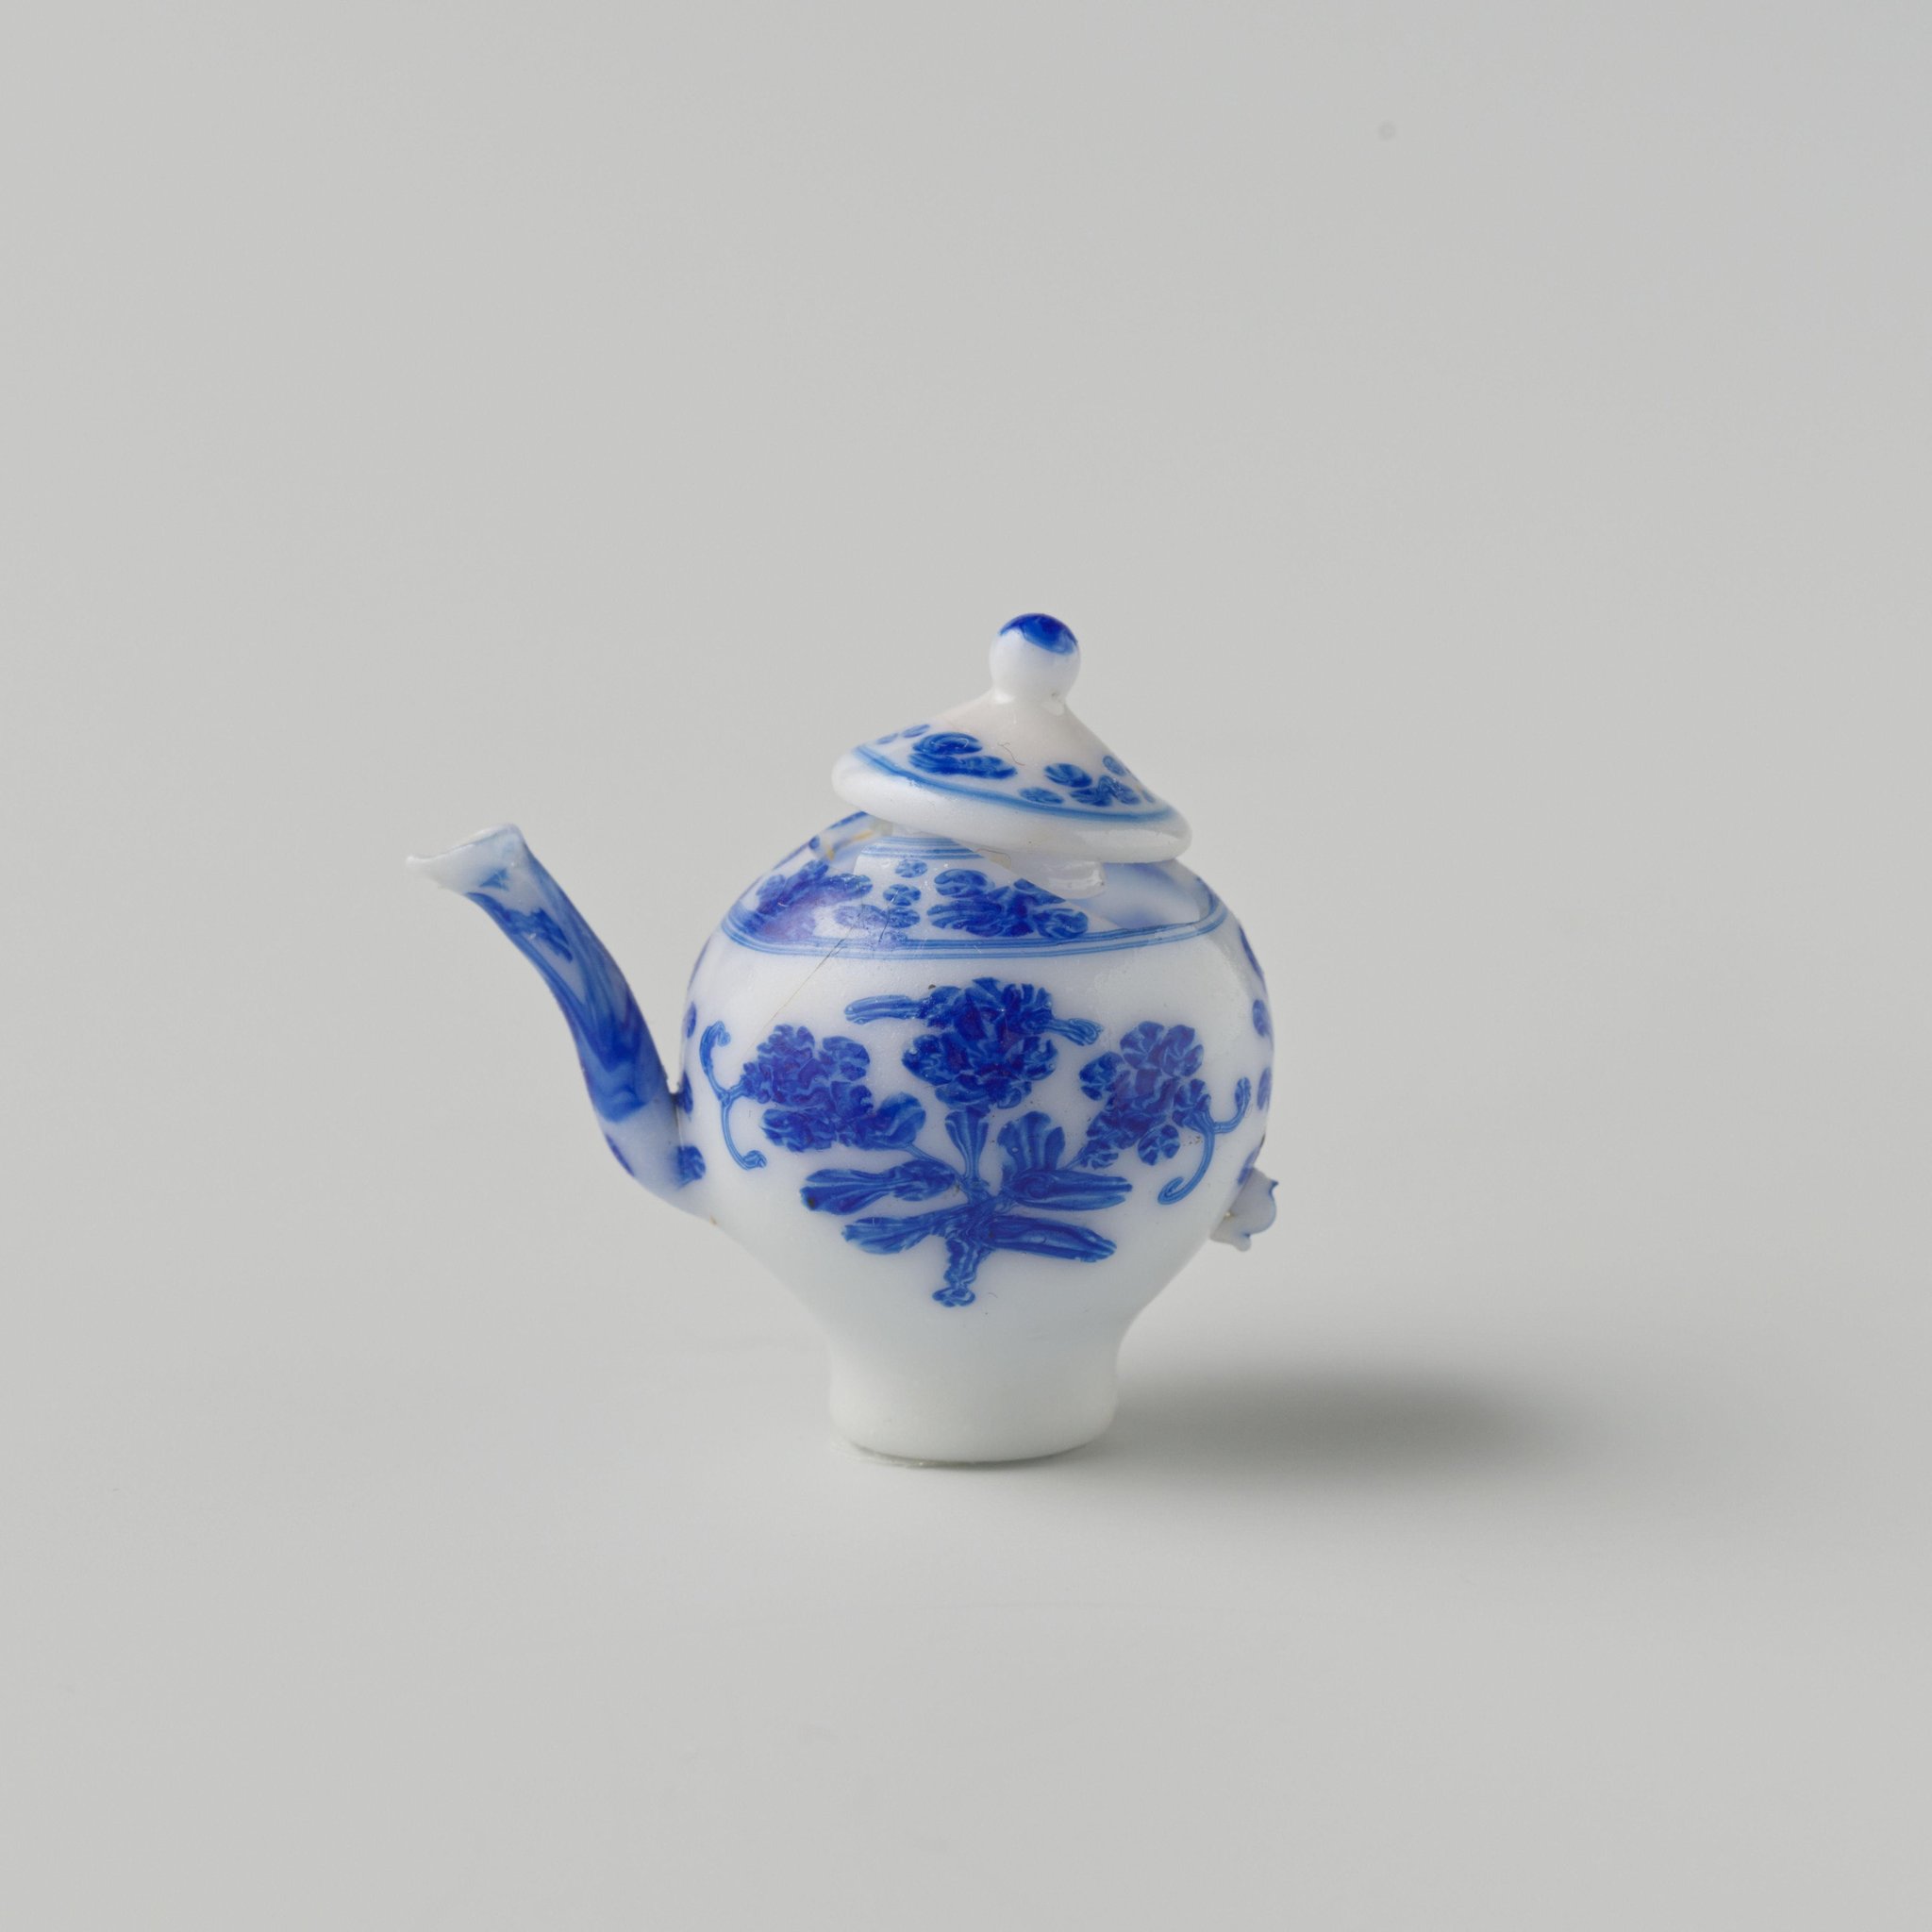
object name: miniature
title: Thee- of trekpot van melkglas met blauwe emailverf beschildering, imitatie Chinees porselein; bolvormig op hoge voet met tuit, oor (ontbreekt) en deksel.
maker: Anonymous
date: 1675-1710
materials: glass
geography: amsterdam